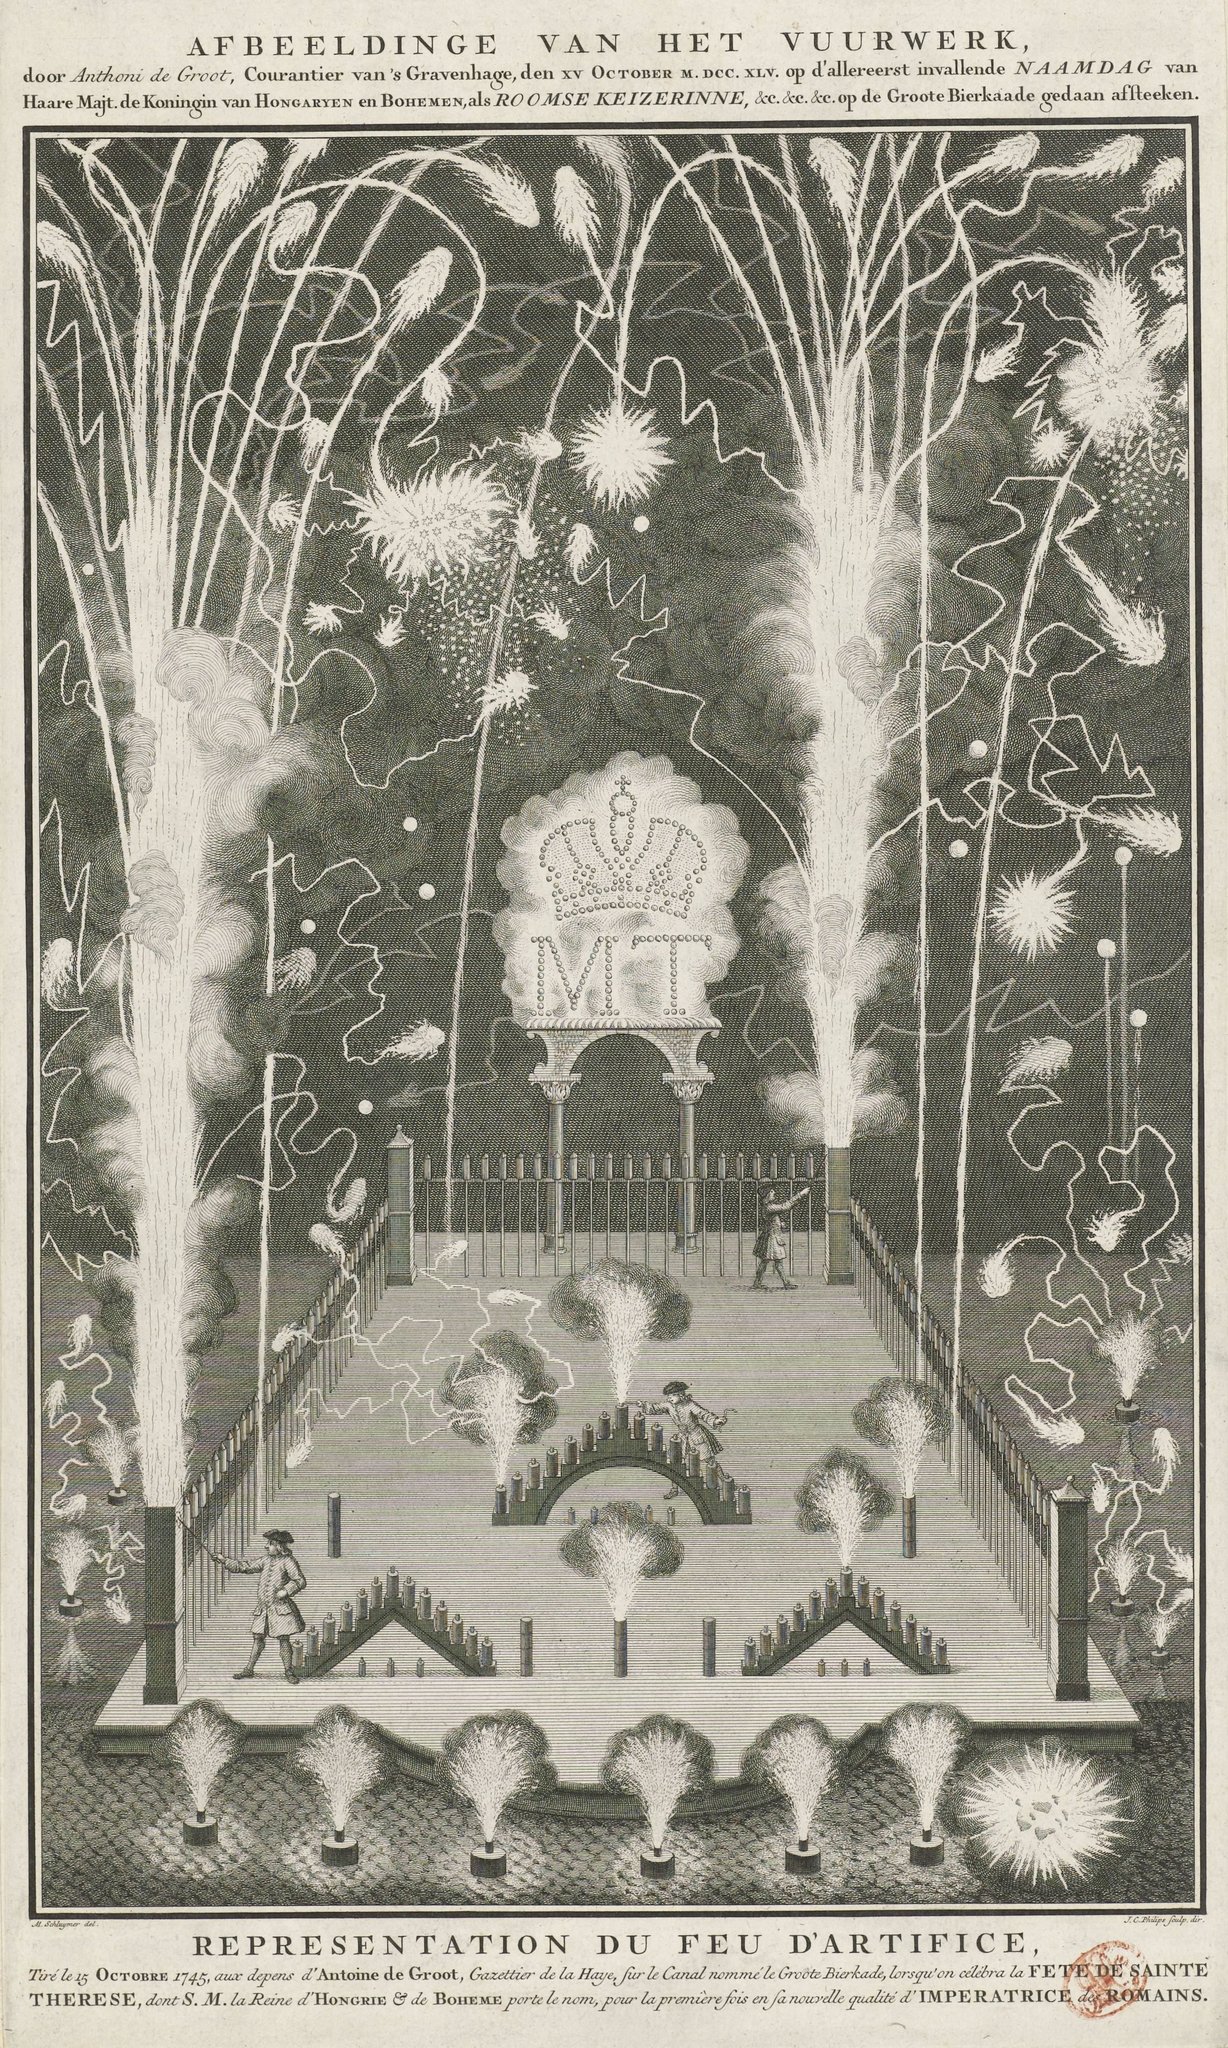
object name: print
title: Vuurwerk afgestoken op 15 oktober 1745, de naamdag van Maria Theresia, in opdracht van Anthoni de Groot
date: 1745-1747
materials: paper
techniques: engraving, etching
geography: the hague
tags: publisher, anthoni de groot, frans i stefan (duits keizer), bonfire, fire-works (+ illumination, fire-works ~ festive activities), the hague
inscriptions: collector's mark: Lugt 195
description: Vuurwerk afgestoken op 15 oktober 1745, de naamdag van Maria Theresia, in opdracht van de uitgever Anthoni de Groot op de Grote Bierkade te Den Haag.